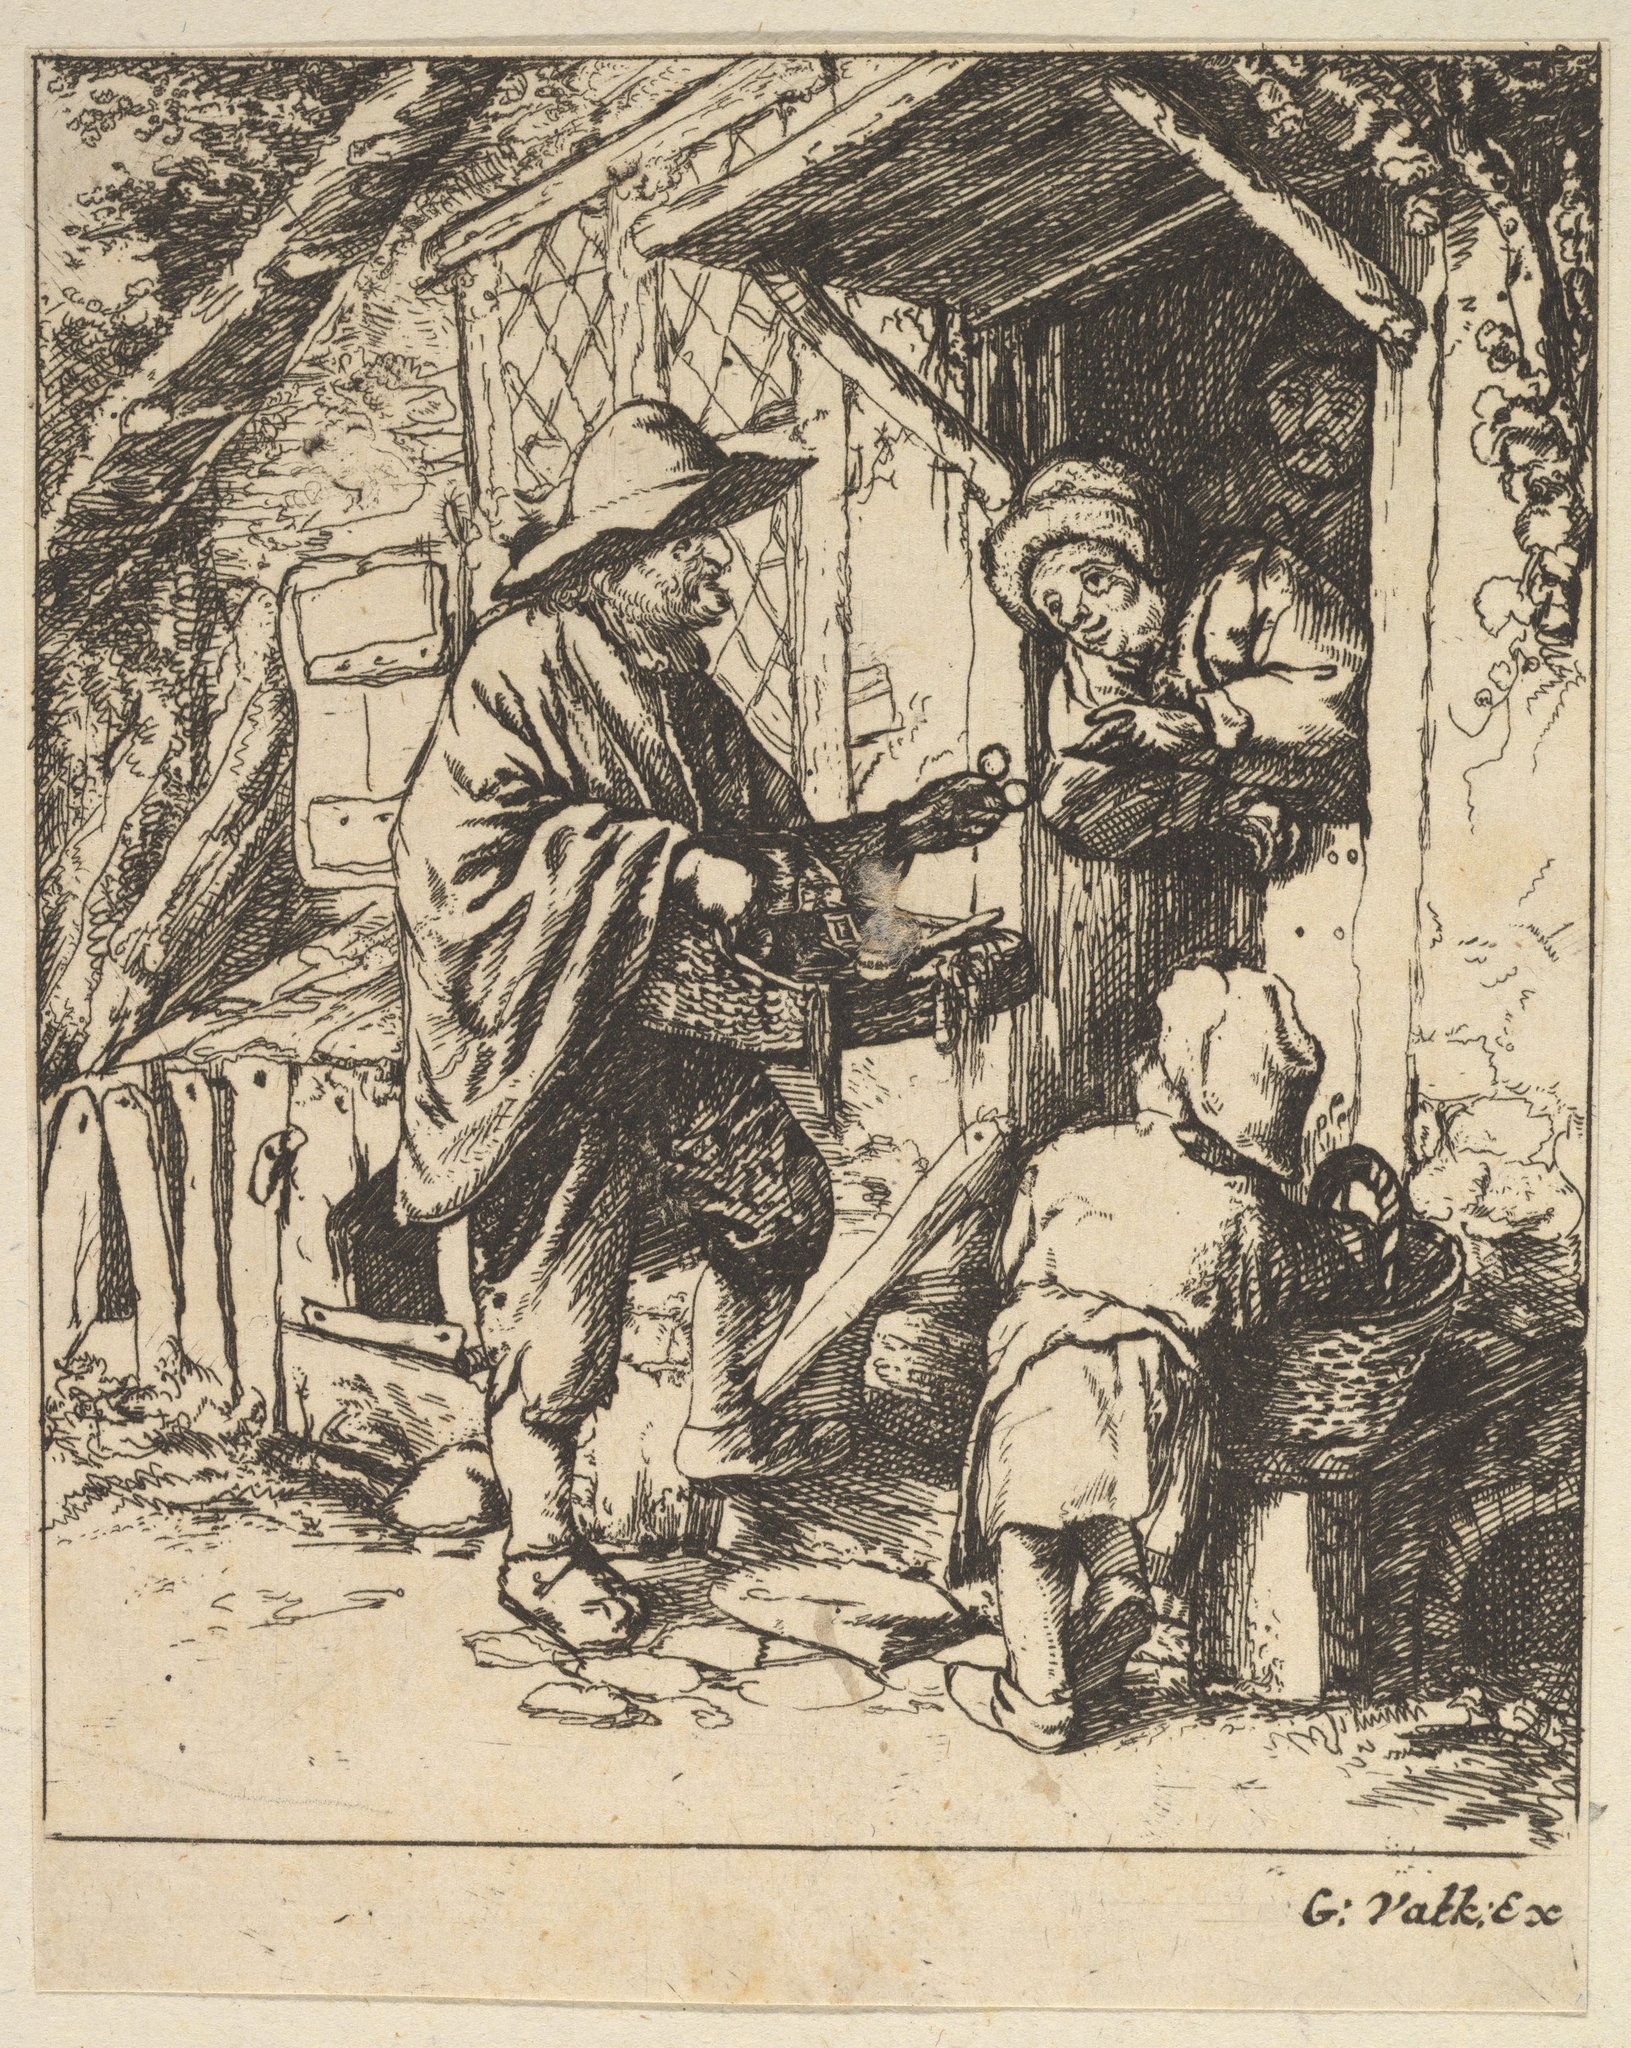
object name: print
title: Eyeglass Merchant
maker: adriaen van ostade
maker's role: artist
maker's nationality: dutch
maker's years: 1610-1685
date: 1610-1685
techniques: etching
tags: men,women,merchants